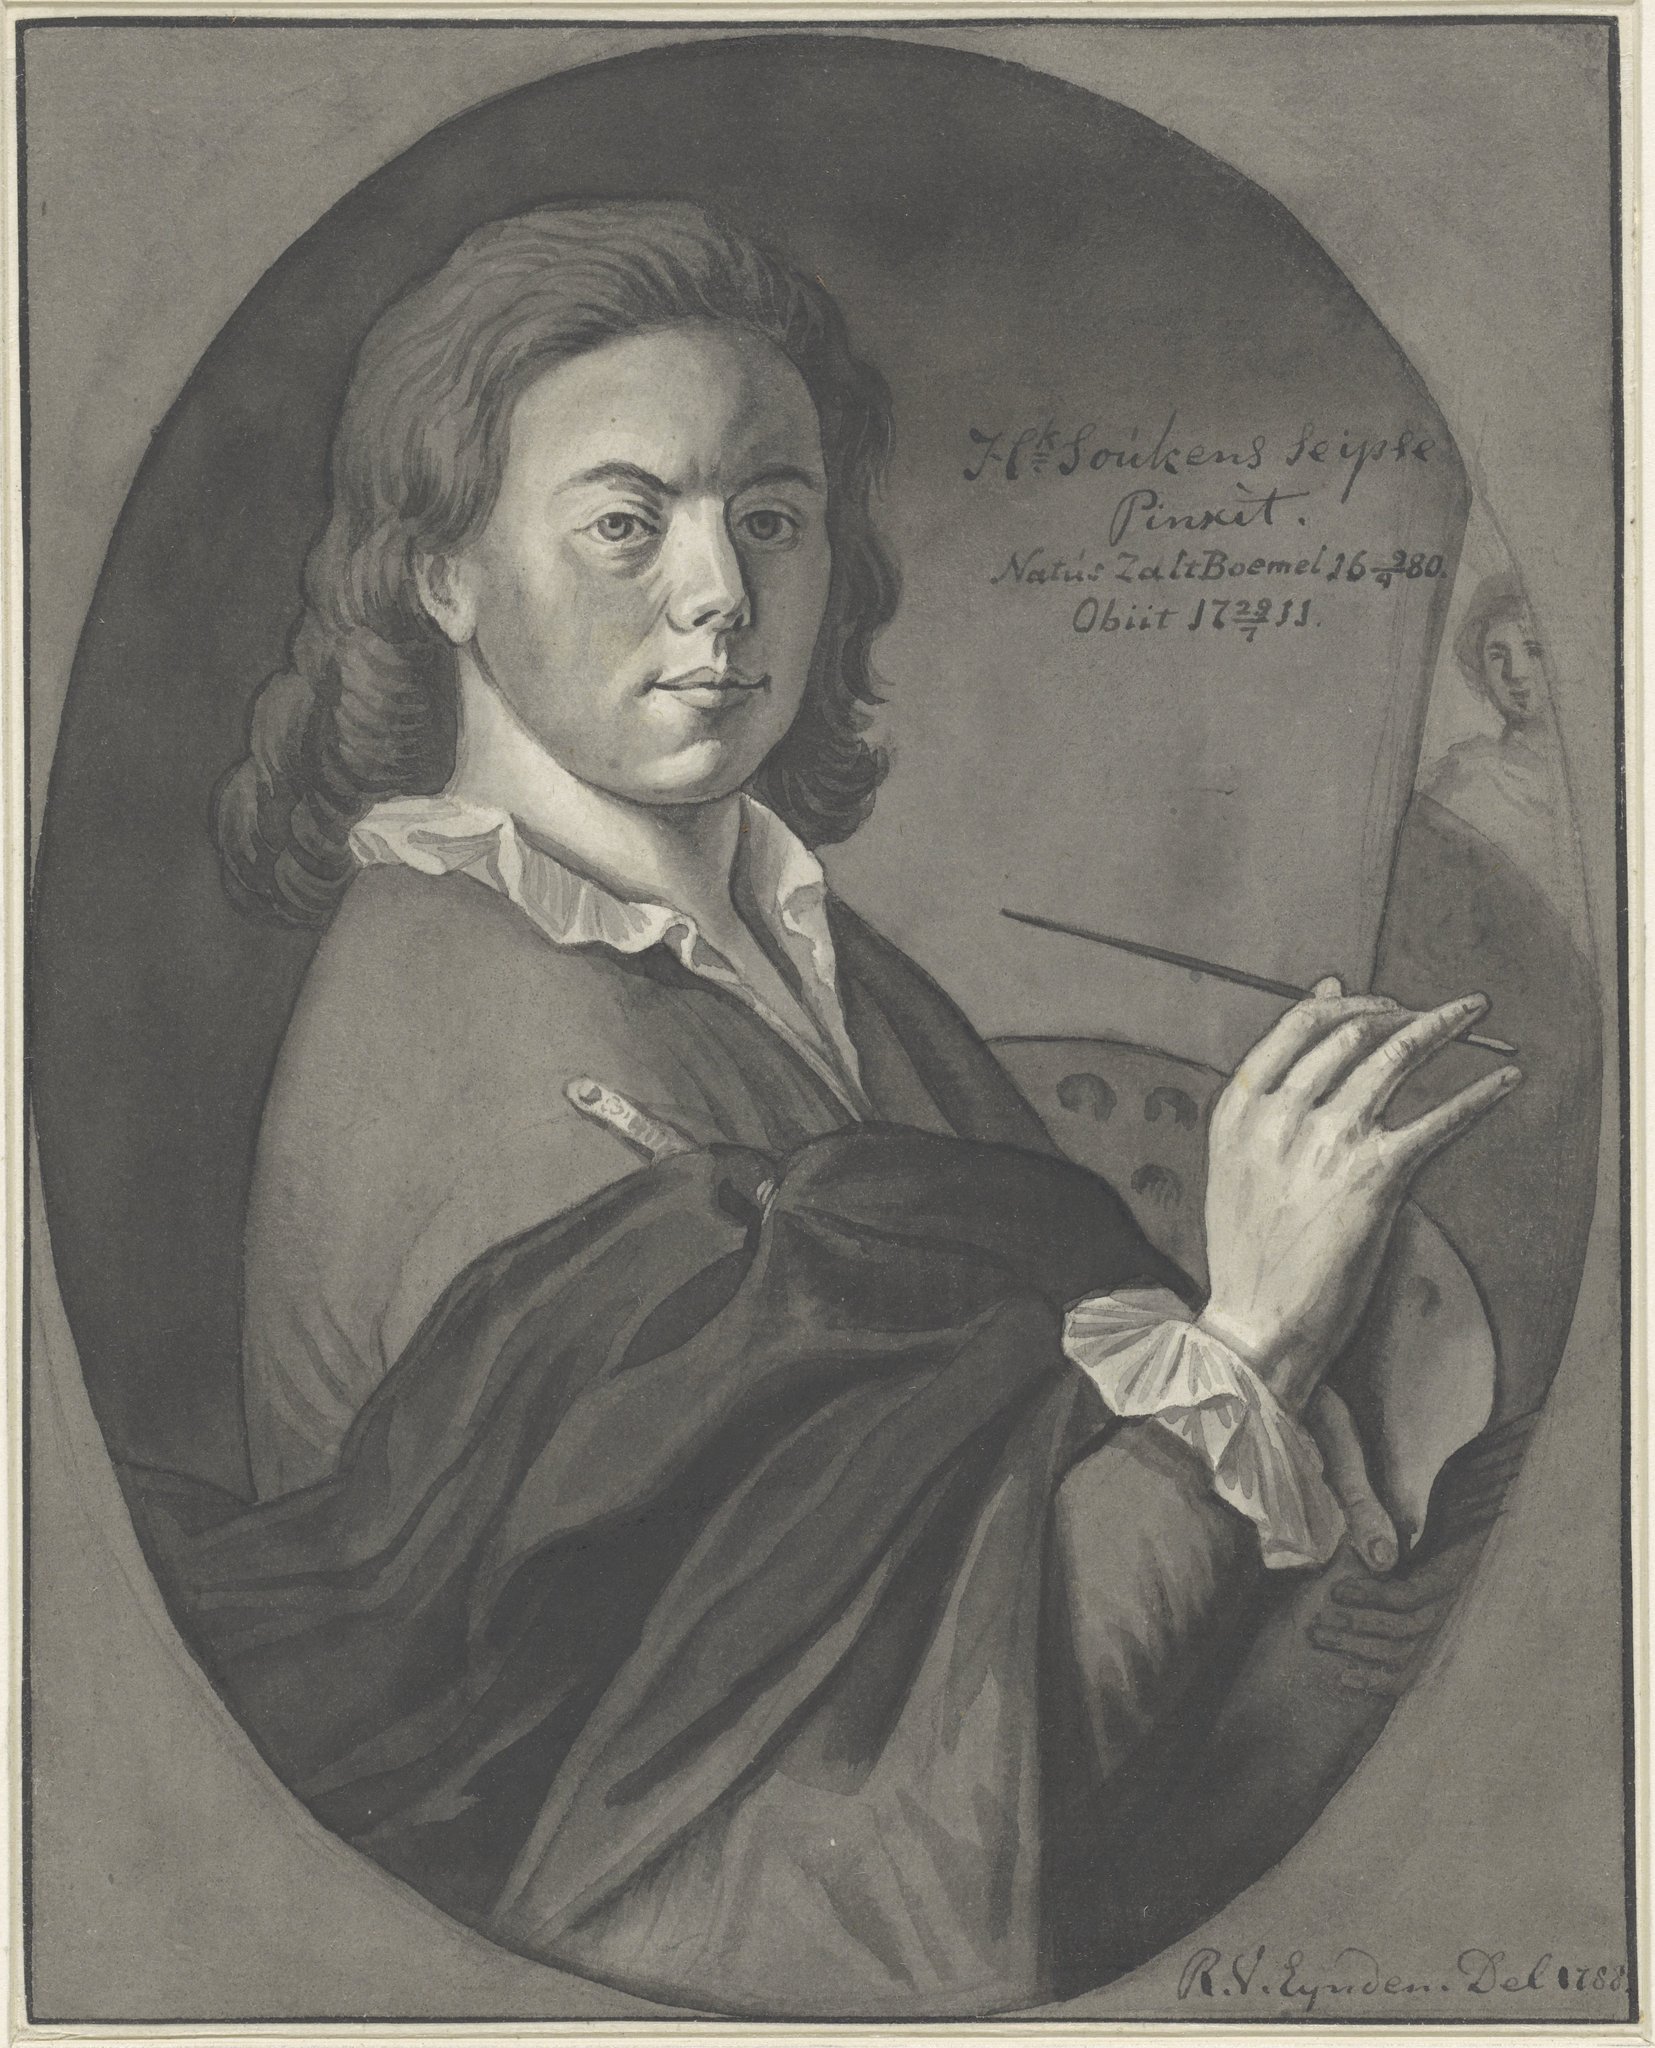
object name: drawing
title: Portret van Hendrik Soukens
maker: roeland van eynden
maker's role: draughtsman, print maker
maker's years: 1747-1819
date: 1788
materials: paper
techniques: brush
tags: hendrik soukens, historical persons, portrait, self-portrait of artist